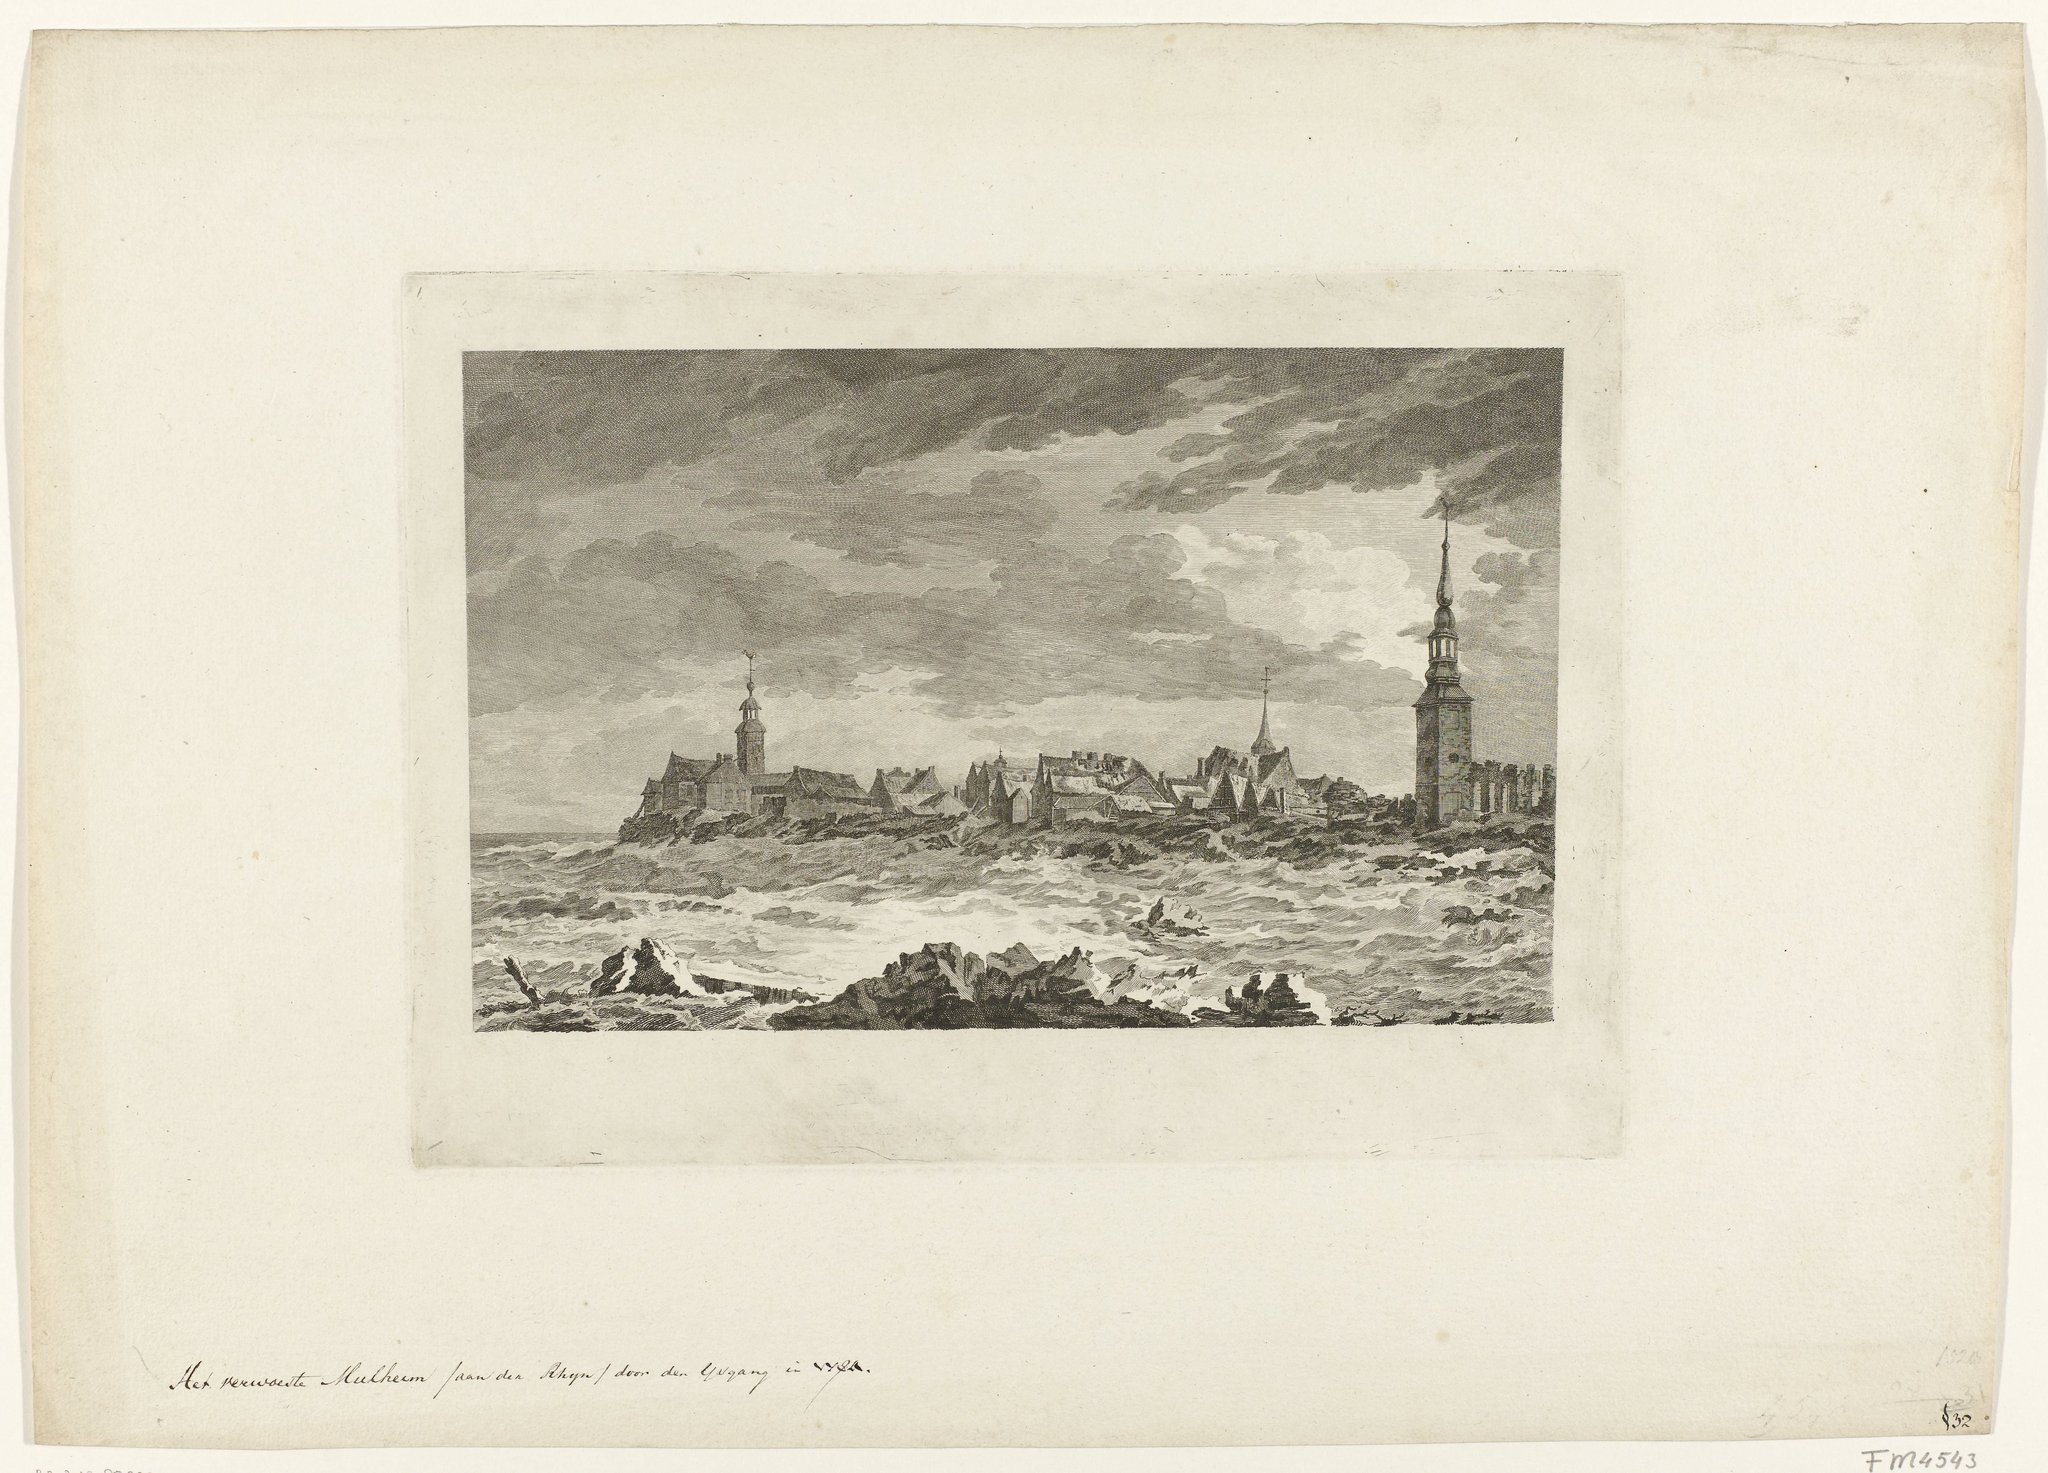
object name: print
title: IJsgang in Mülheim aan de Rijn, 1784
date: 1784-1785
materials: paper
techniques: engraving, etching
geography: northern netherlands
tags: drift ice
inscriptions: collector's mark: Lugt 2228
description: Gebruikt als illustratie in: Naauwkeurige beschryving der overstroomingen, benevens derzelver treurige gevolgen (...) in den jaare MDCCLXXXIV voorgevallen. Leiden: F. de Does, Amsterdam: I. de Jongh, 1785.